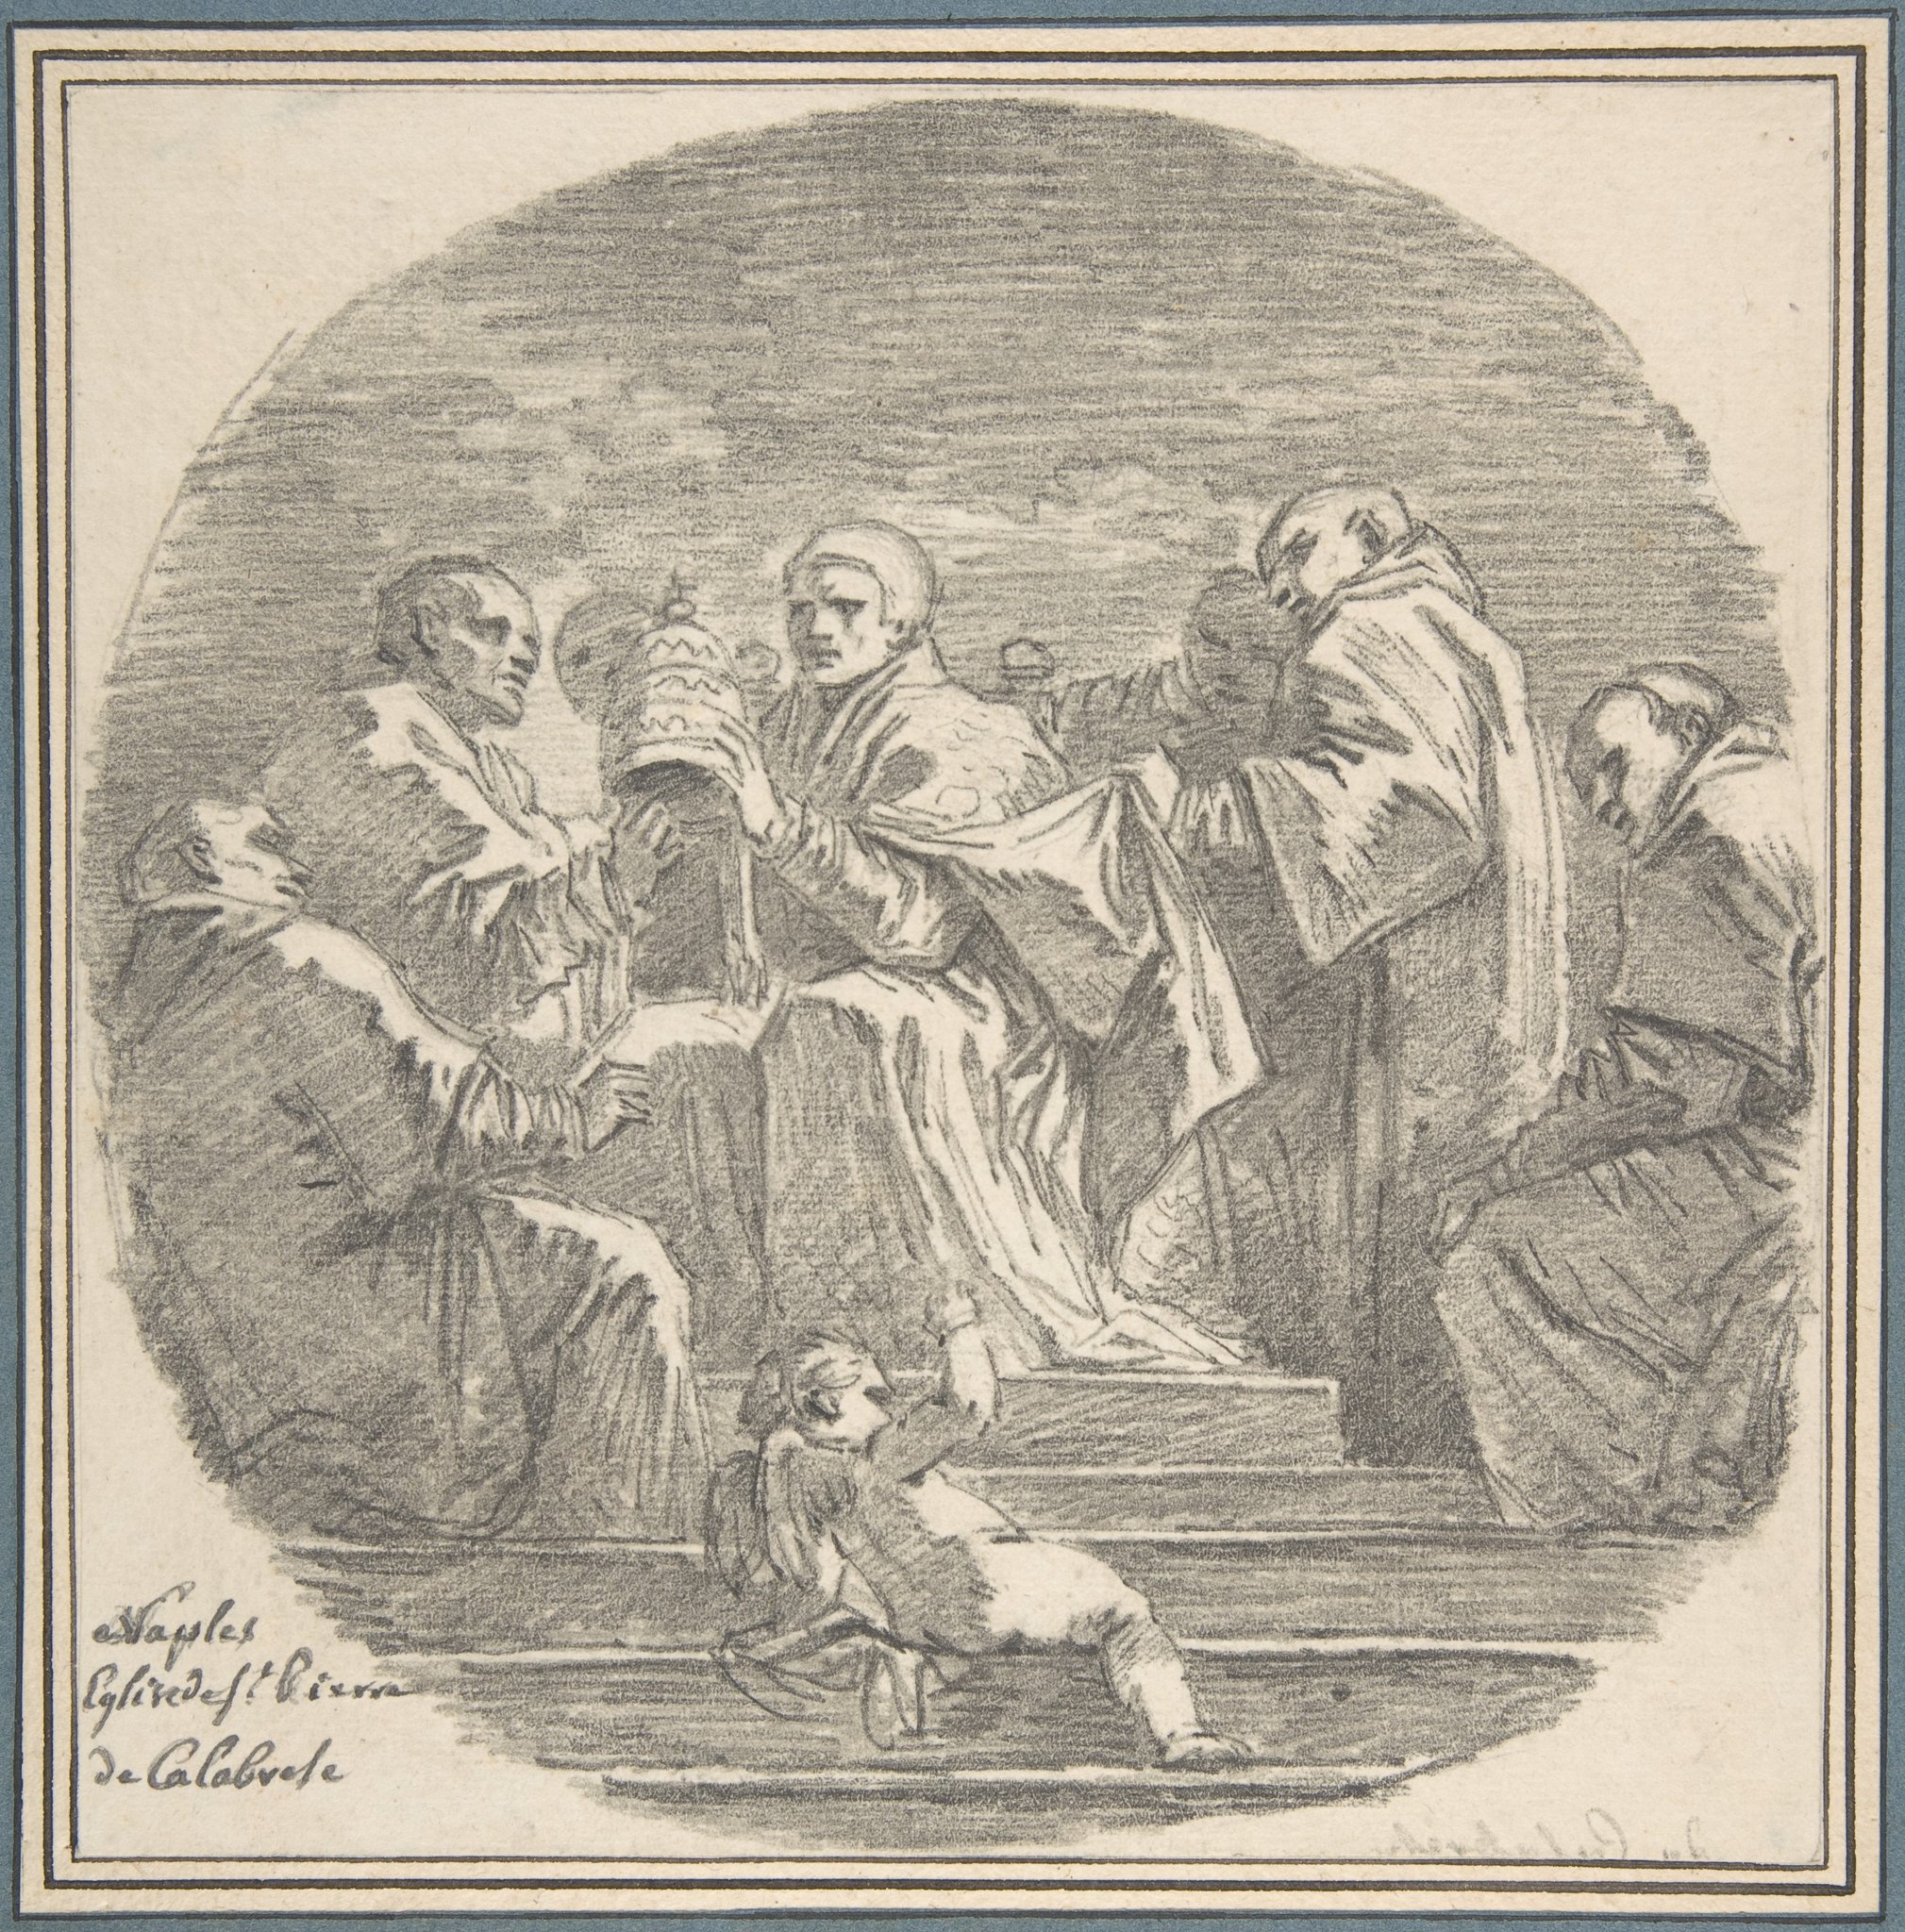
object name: drawing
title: Saint Celestine V Renouncing the Papacy, after Mattia Preti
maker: jean honoré fragonard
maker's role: artist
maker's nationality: french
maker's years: 1732-1806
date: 1761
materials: chalk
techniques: printmaking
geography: france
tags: men,saints